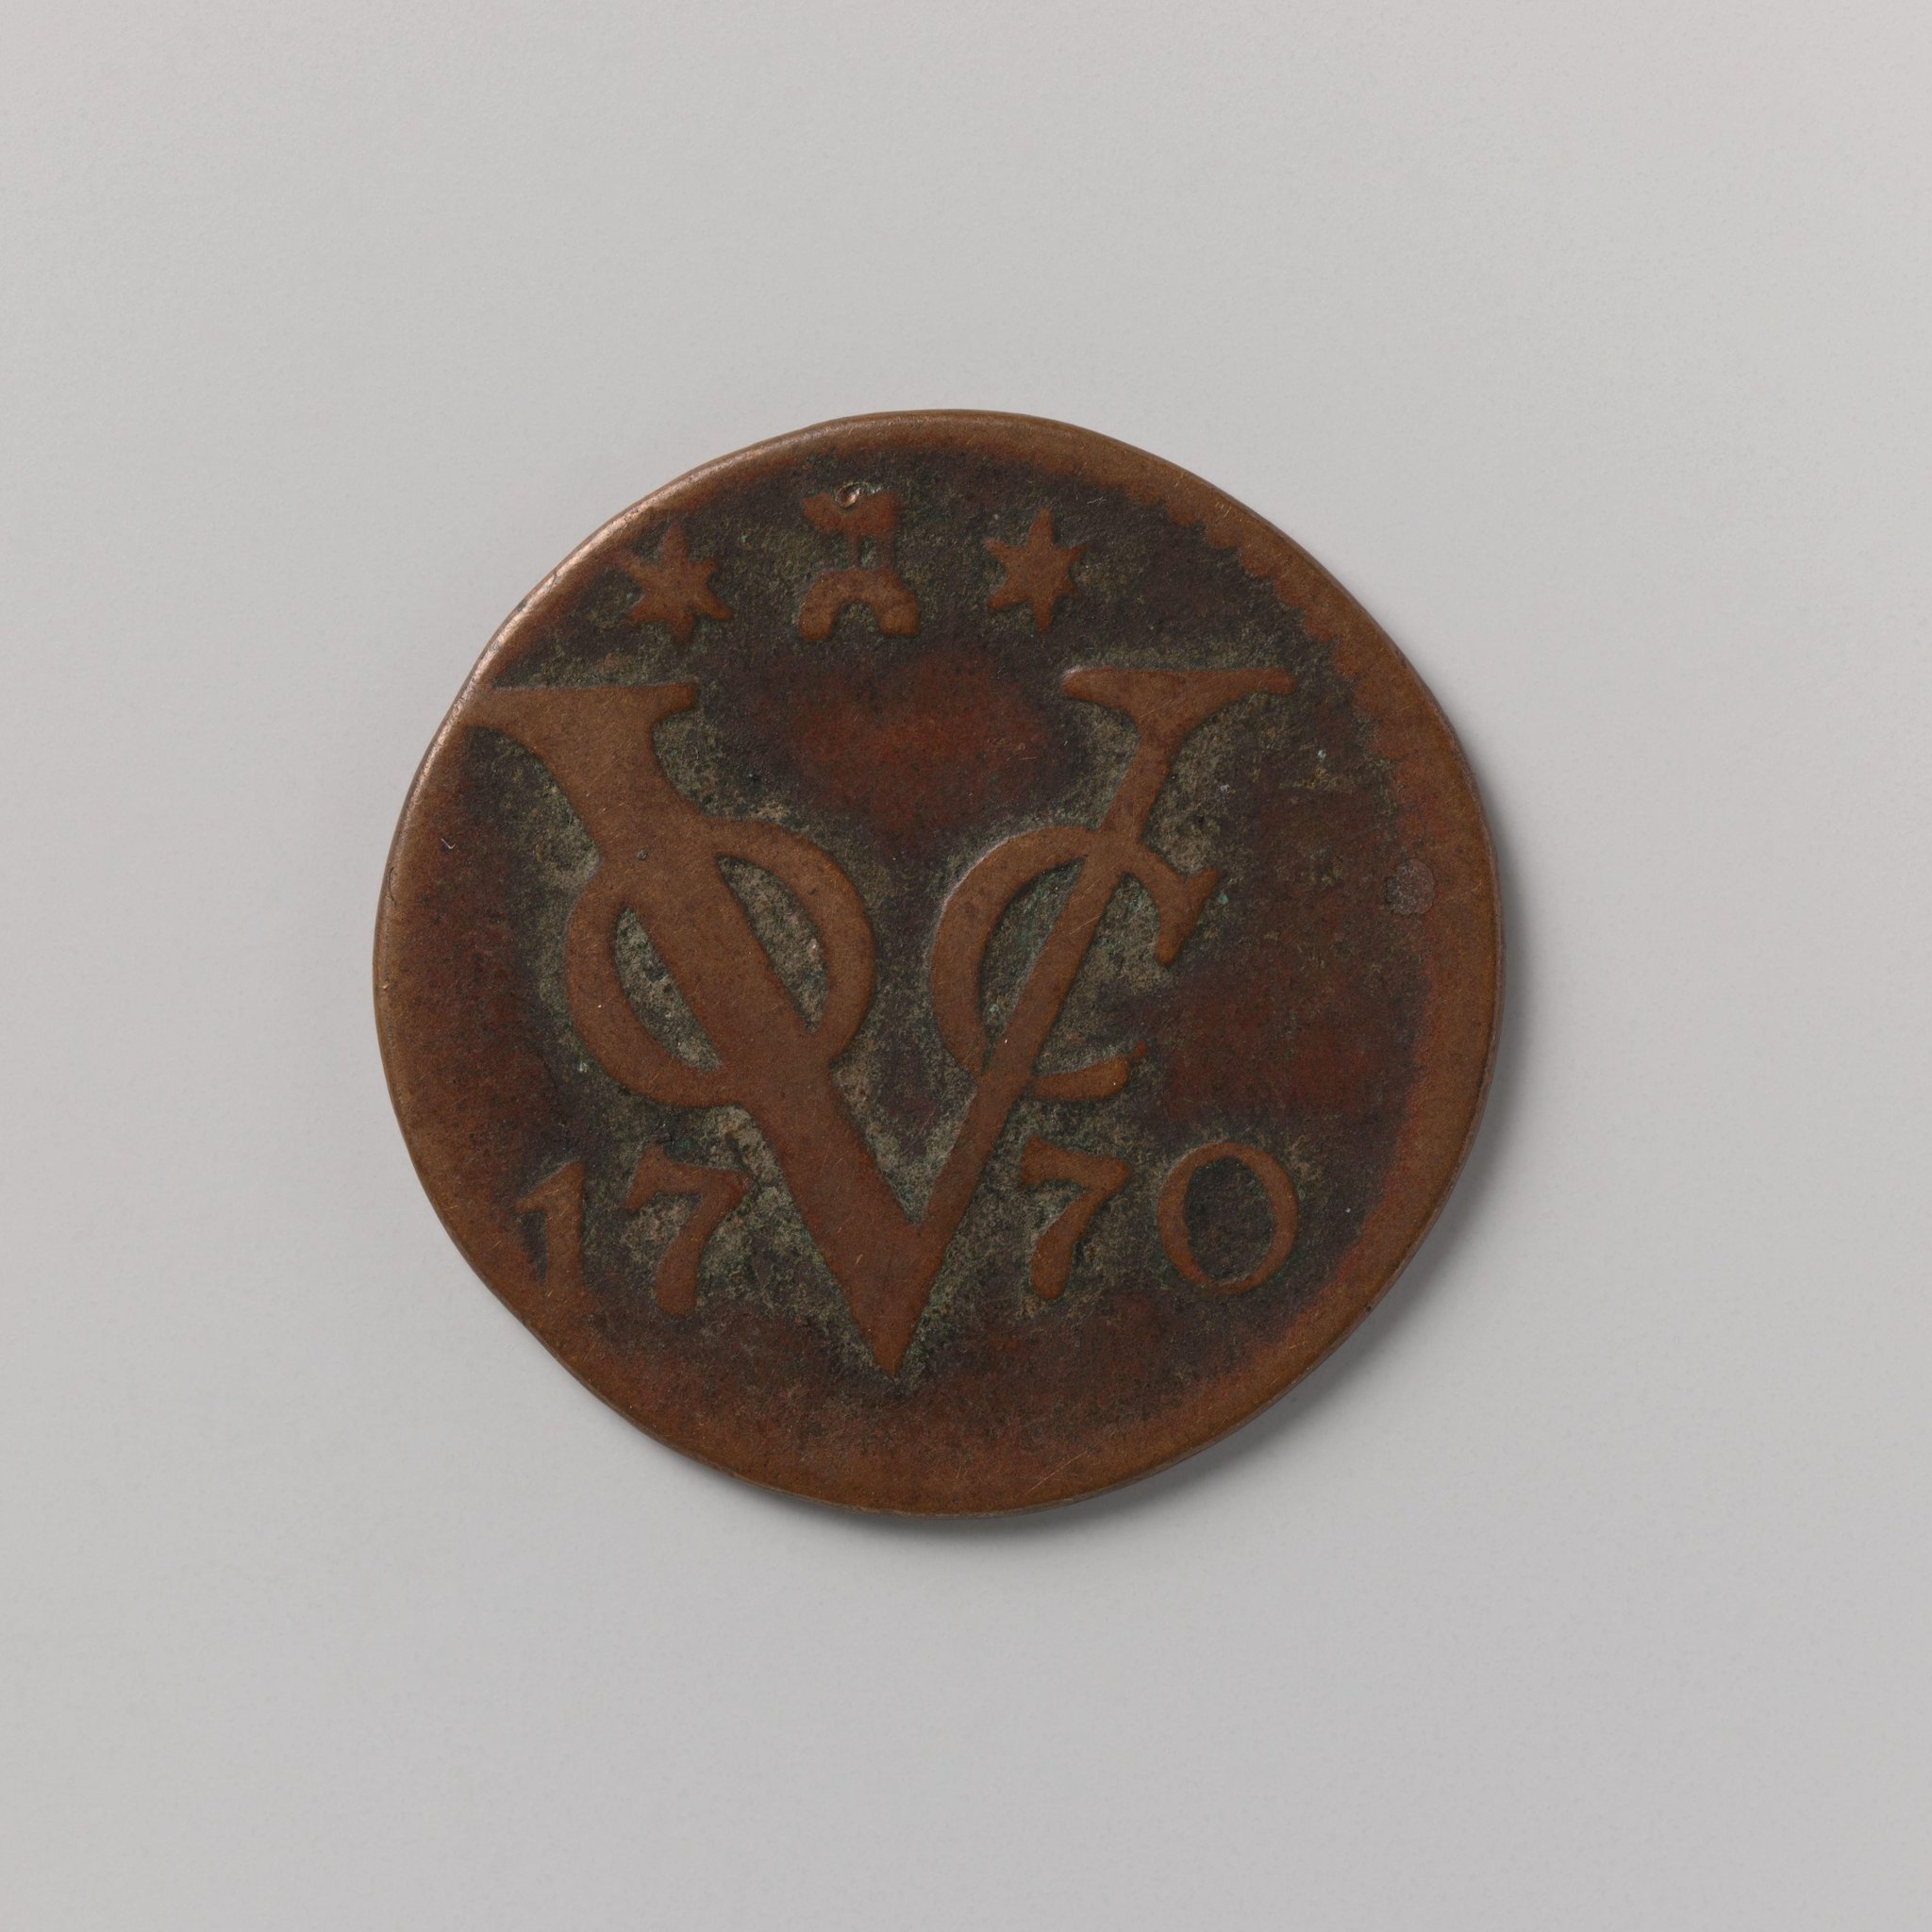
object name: coin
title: VOC, duit Zeeland, 1770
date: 1770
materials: copper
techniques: striking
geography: middelburg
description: Koperen munt. Voorzijde: gekroond wapenschild van Zeeland. Keerzijde: monogram van de VOC, waarboven muntteken en waaronder jaartal. Gladde rand.